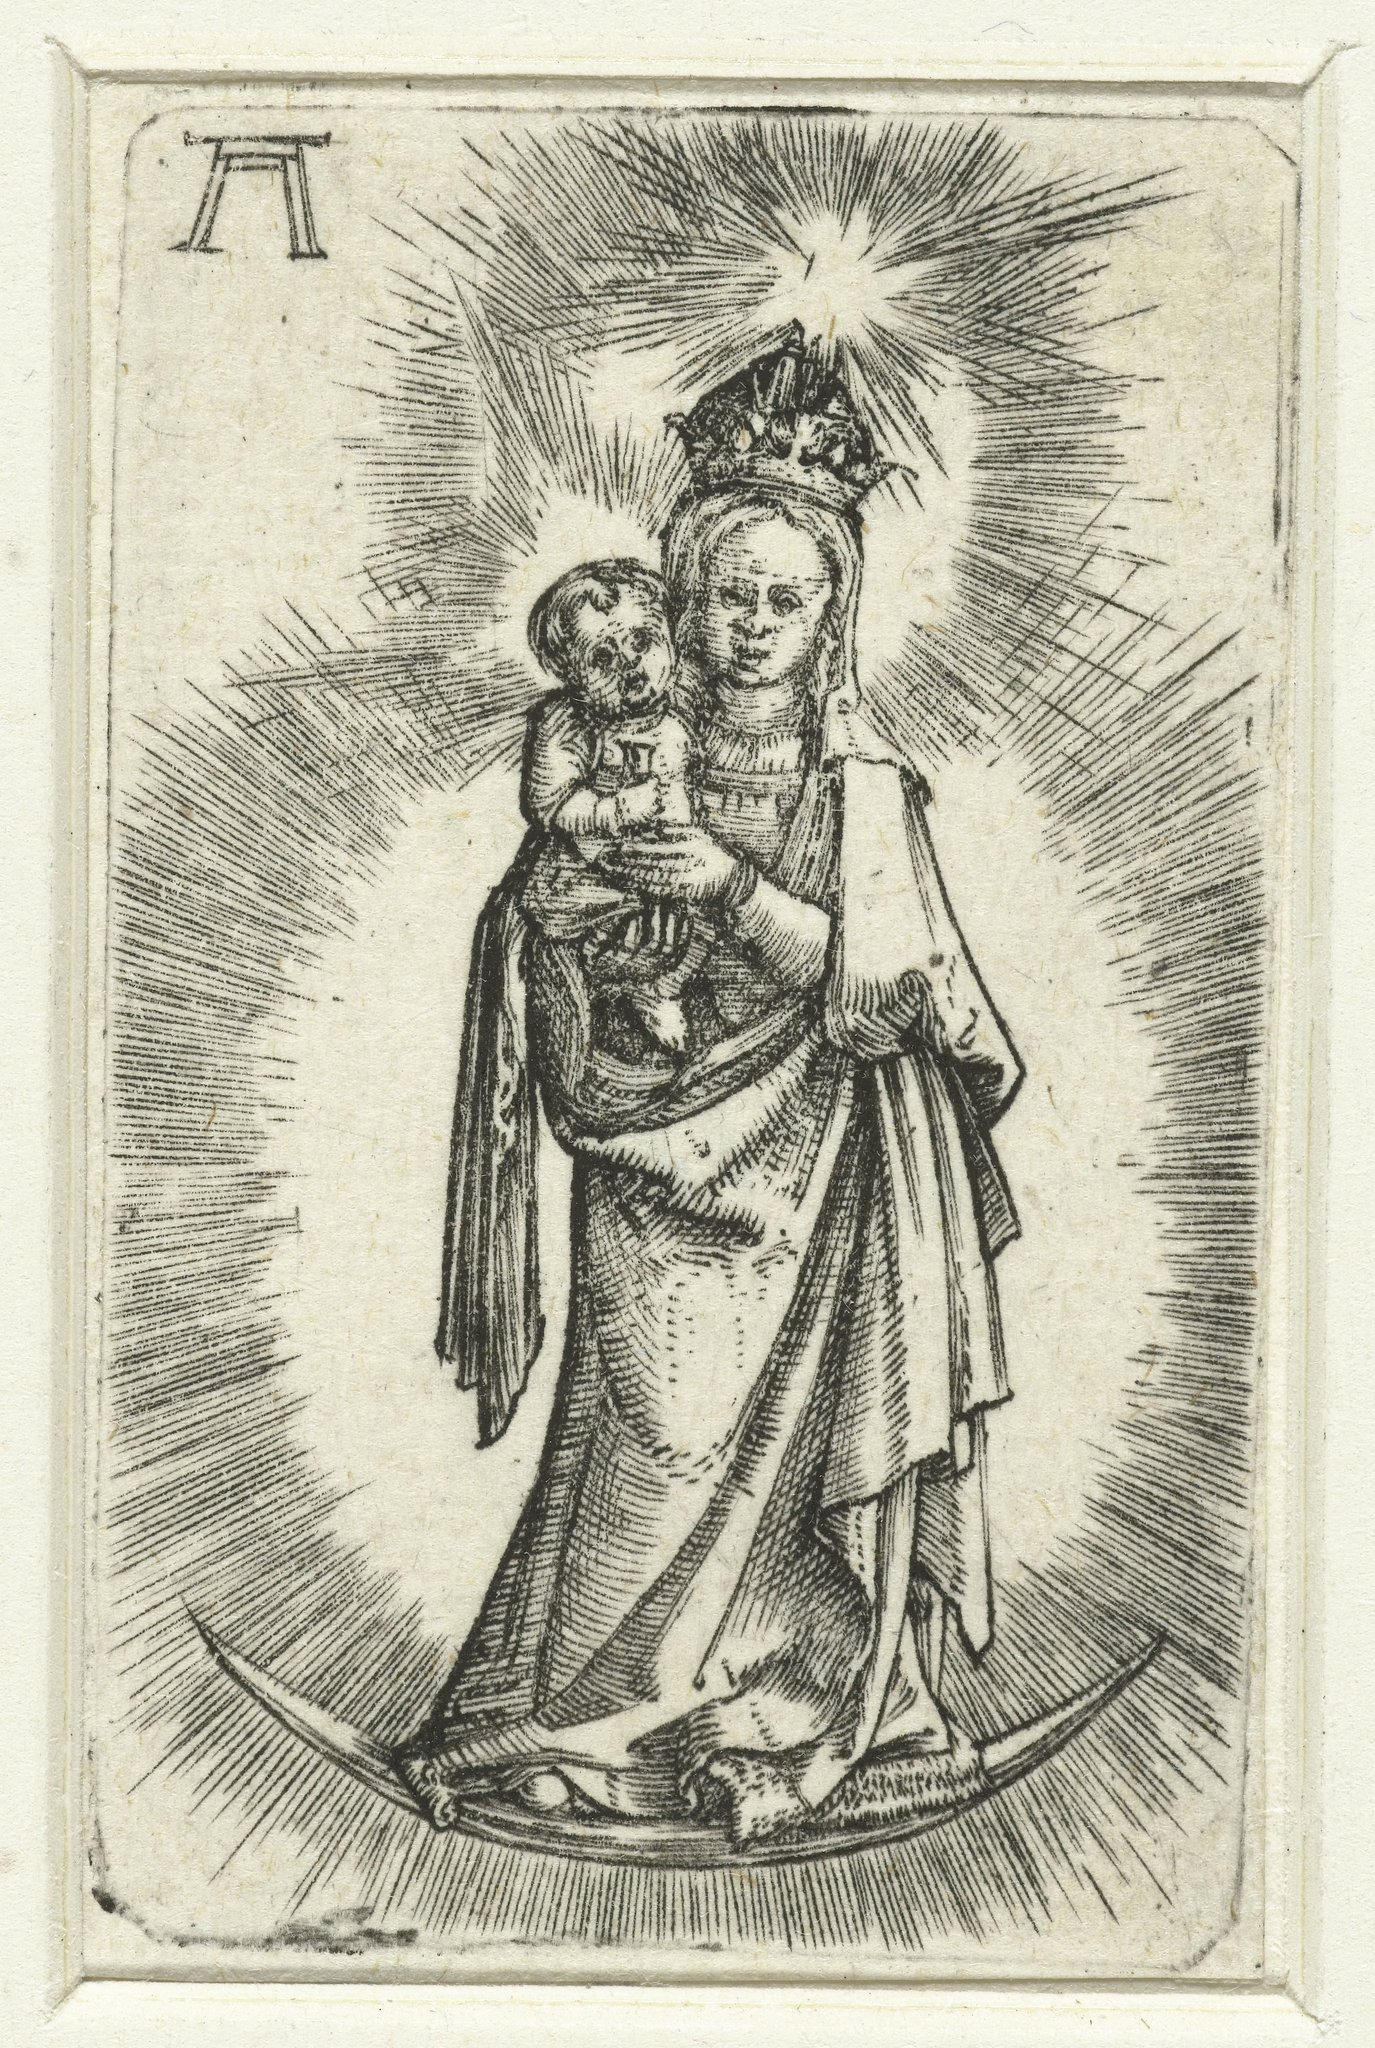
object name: print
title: Madonna op de maansikkel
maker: albrecht altdorfer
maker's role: draughtsman, print maker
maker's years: 1480-1538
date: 1506-1538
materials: paper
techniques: engraving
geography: germany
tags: madonna on the crescent of the moon (sometimes called queen of heaven) (in mandorla)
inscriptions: number: ‘43’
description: Maria, gekroond en met het Christuskind op de arm, staand op een maansikkel.